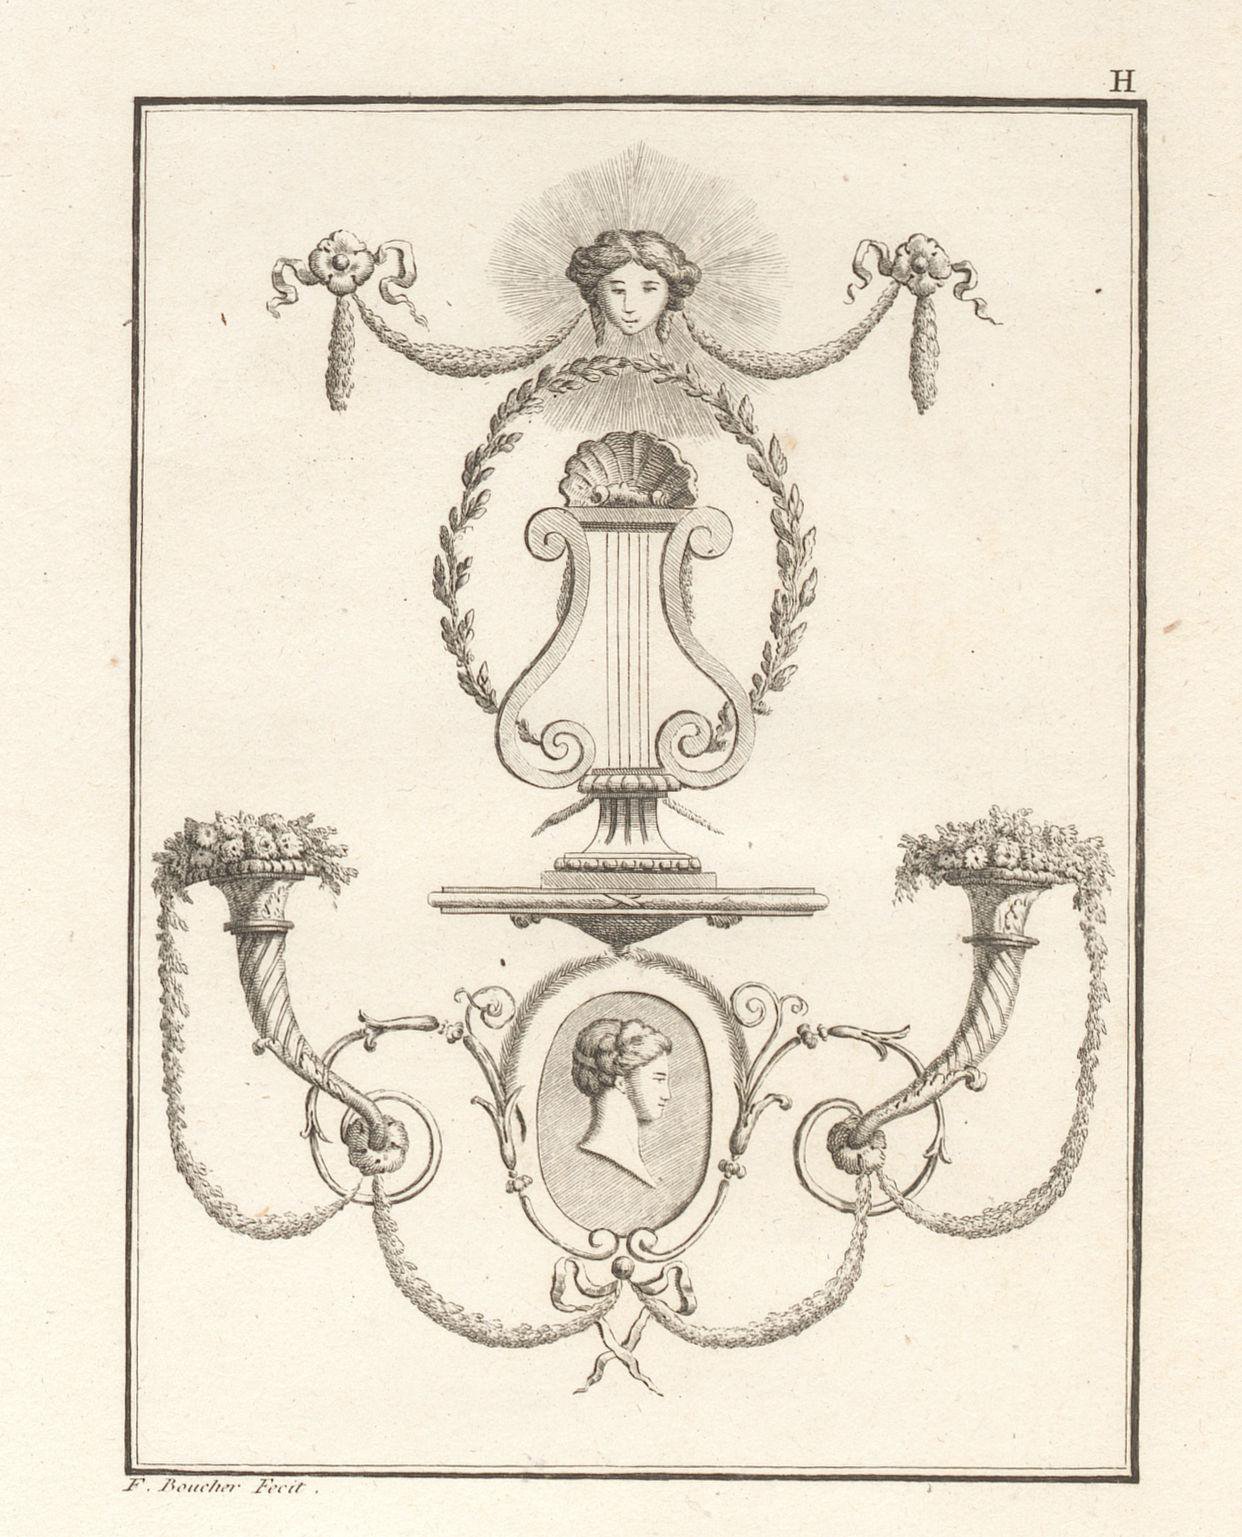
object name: album leaf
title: Verzameling van arabesken, met de Vaticaanse loggia's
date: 1802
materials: paper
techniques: etching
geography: paris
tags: 'cornucopia', horn of plenty, ornament ~ arabesque, lyre, cithara, psaltery, vase ~ ornament, mask, mascaron ~ ornament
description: Doordat dit album bestaat uit meerdere, deels eerder uitgegeven prentreeksen, is de datering niet consequent. Het geheel is op de titelpagina gedateerd op 1802. Deze reeks is niet los gedateerd. De serietitel voor het gehele werk is "Recueil d'arabesques, contenant les loges du Vatican". De andere serietitel is de titel van de specifieke reeks binnen het geheel.